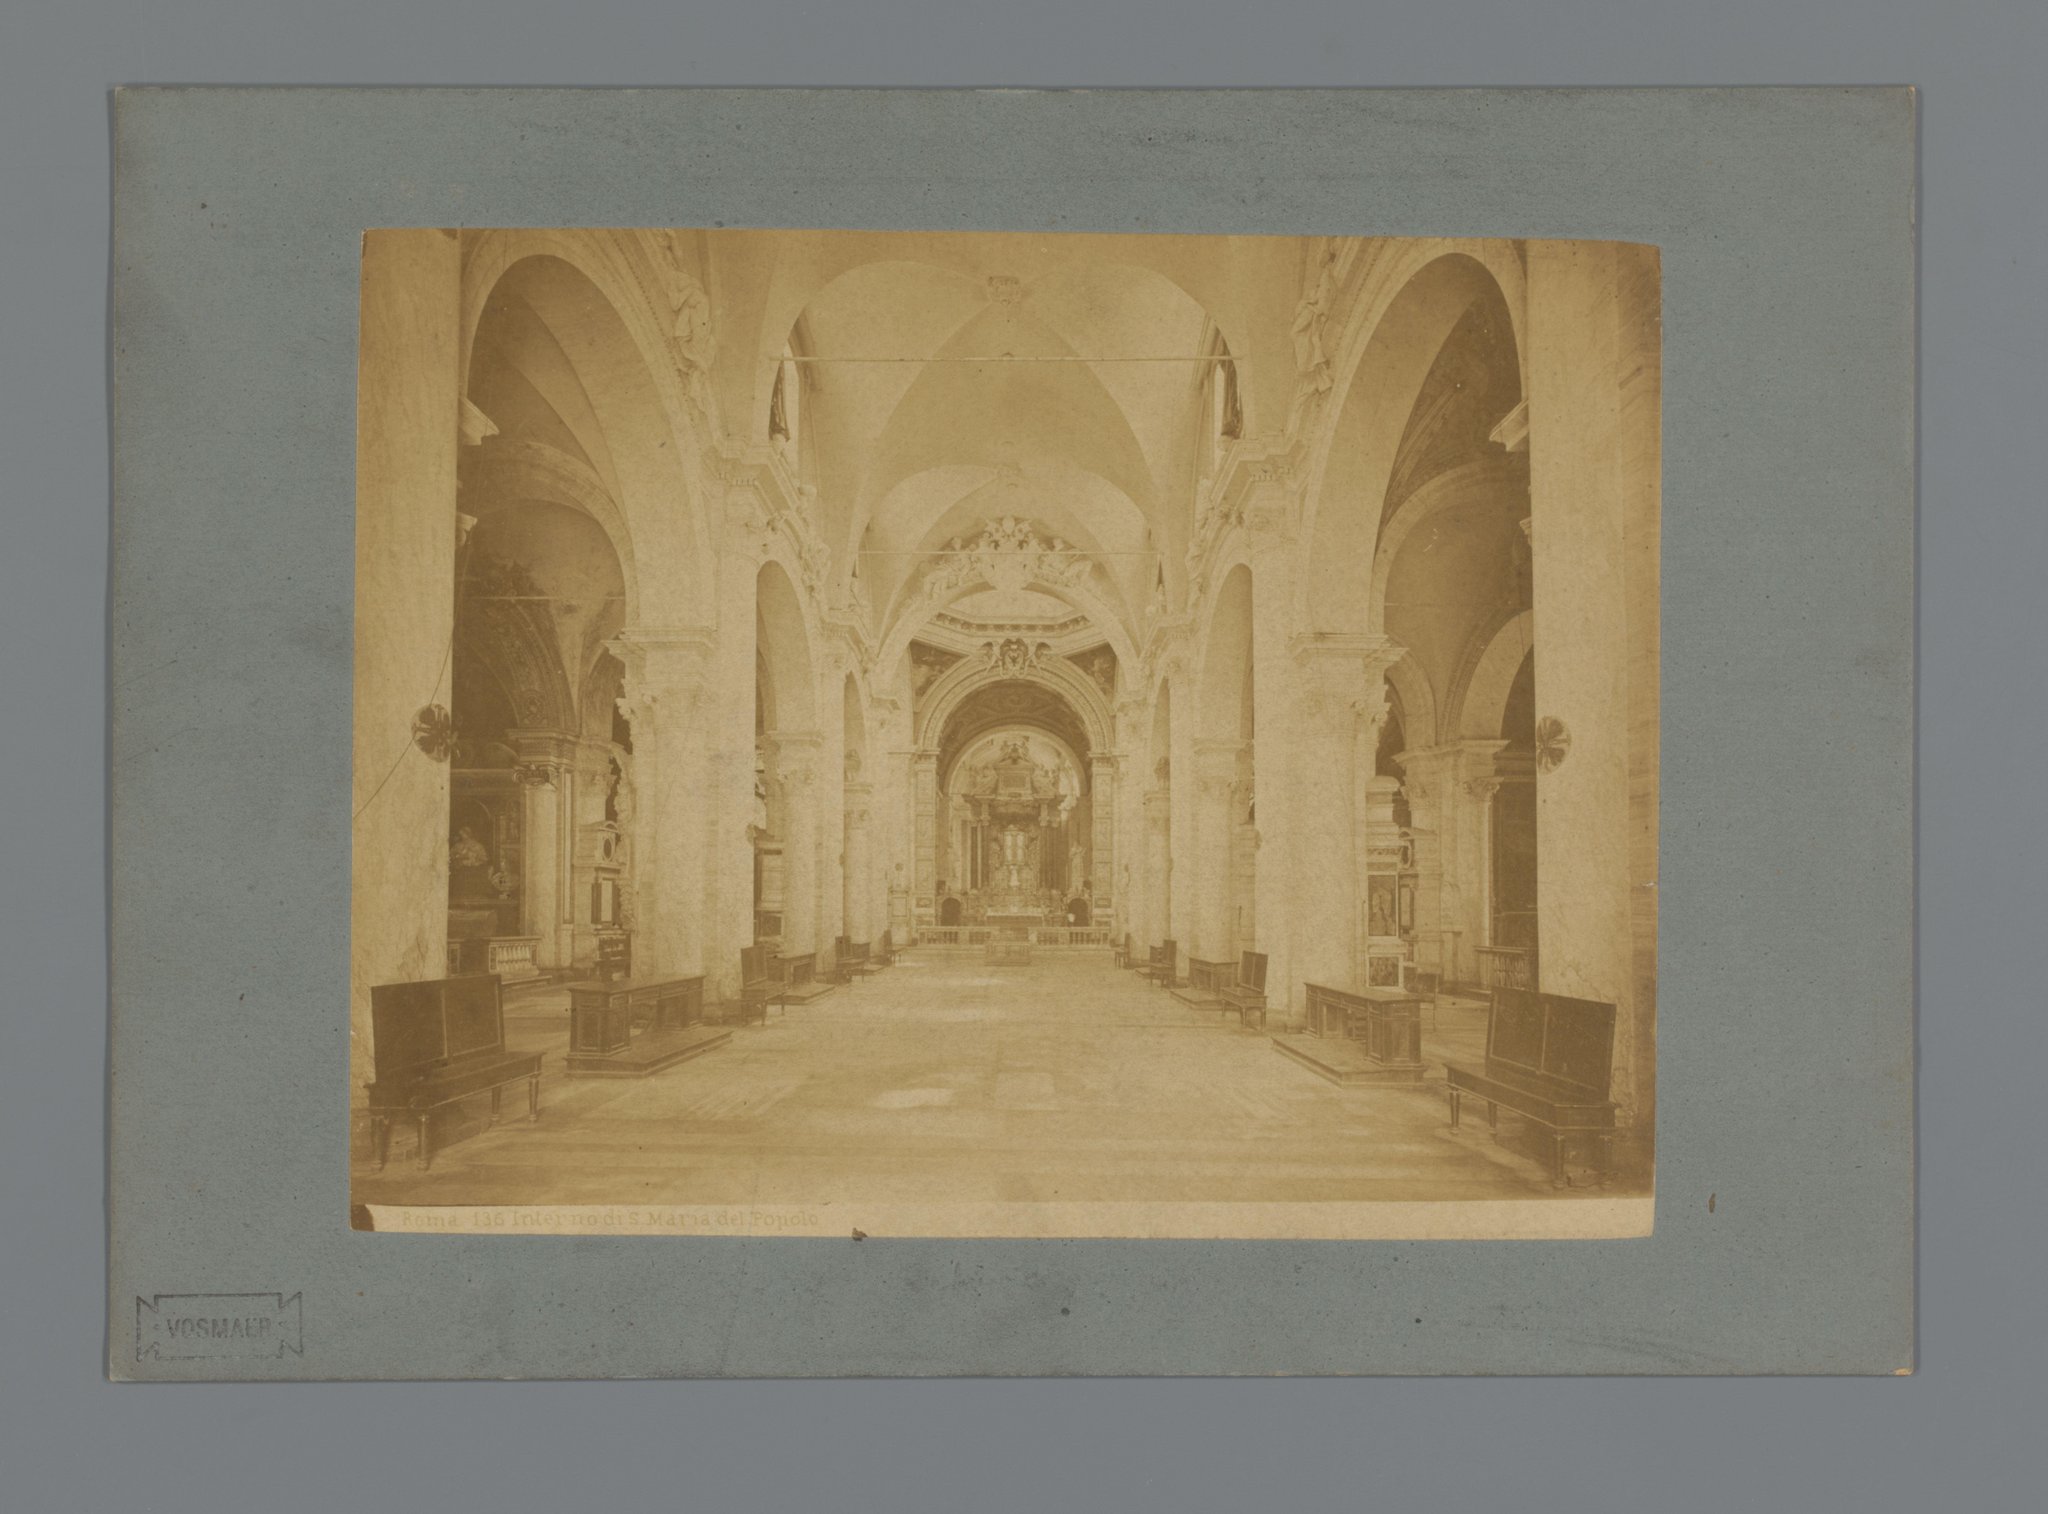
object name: photograph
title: Interieur van de Santa Maria del Popolo te Rome, Italië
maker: Anonymous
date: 1851-1890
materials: cardboard, paper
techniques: albumen print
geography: rome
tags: interior of church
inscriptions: number: ‘136’, collector's mark: ‘VOSMAER’